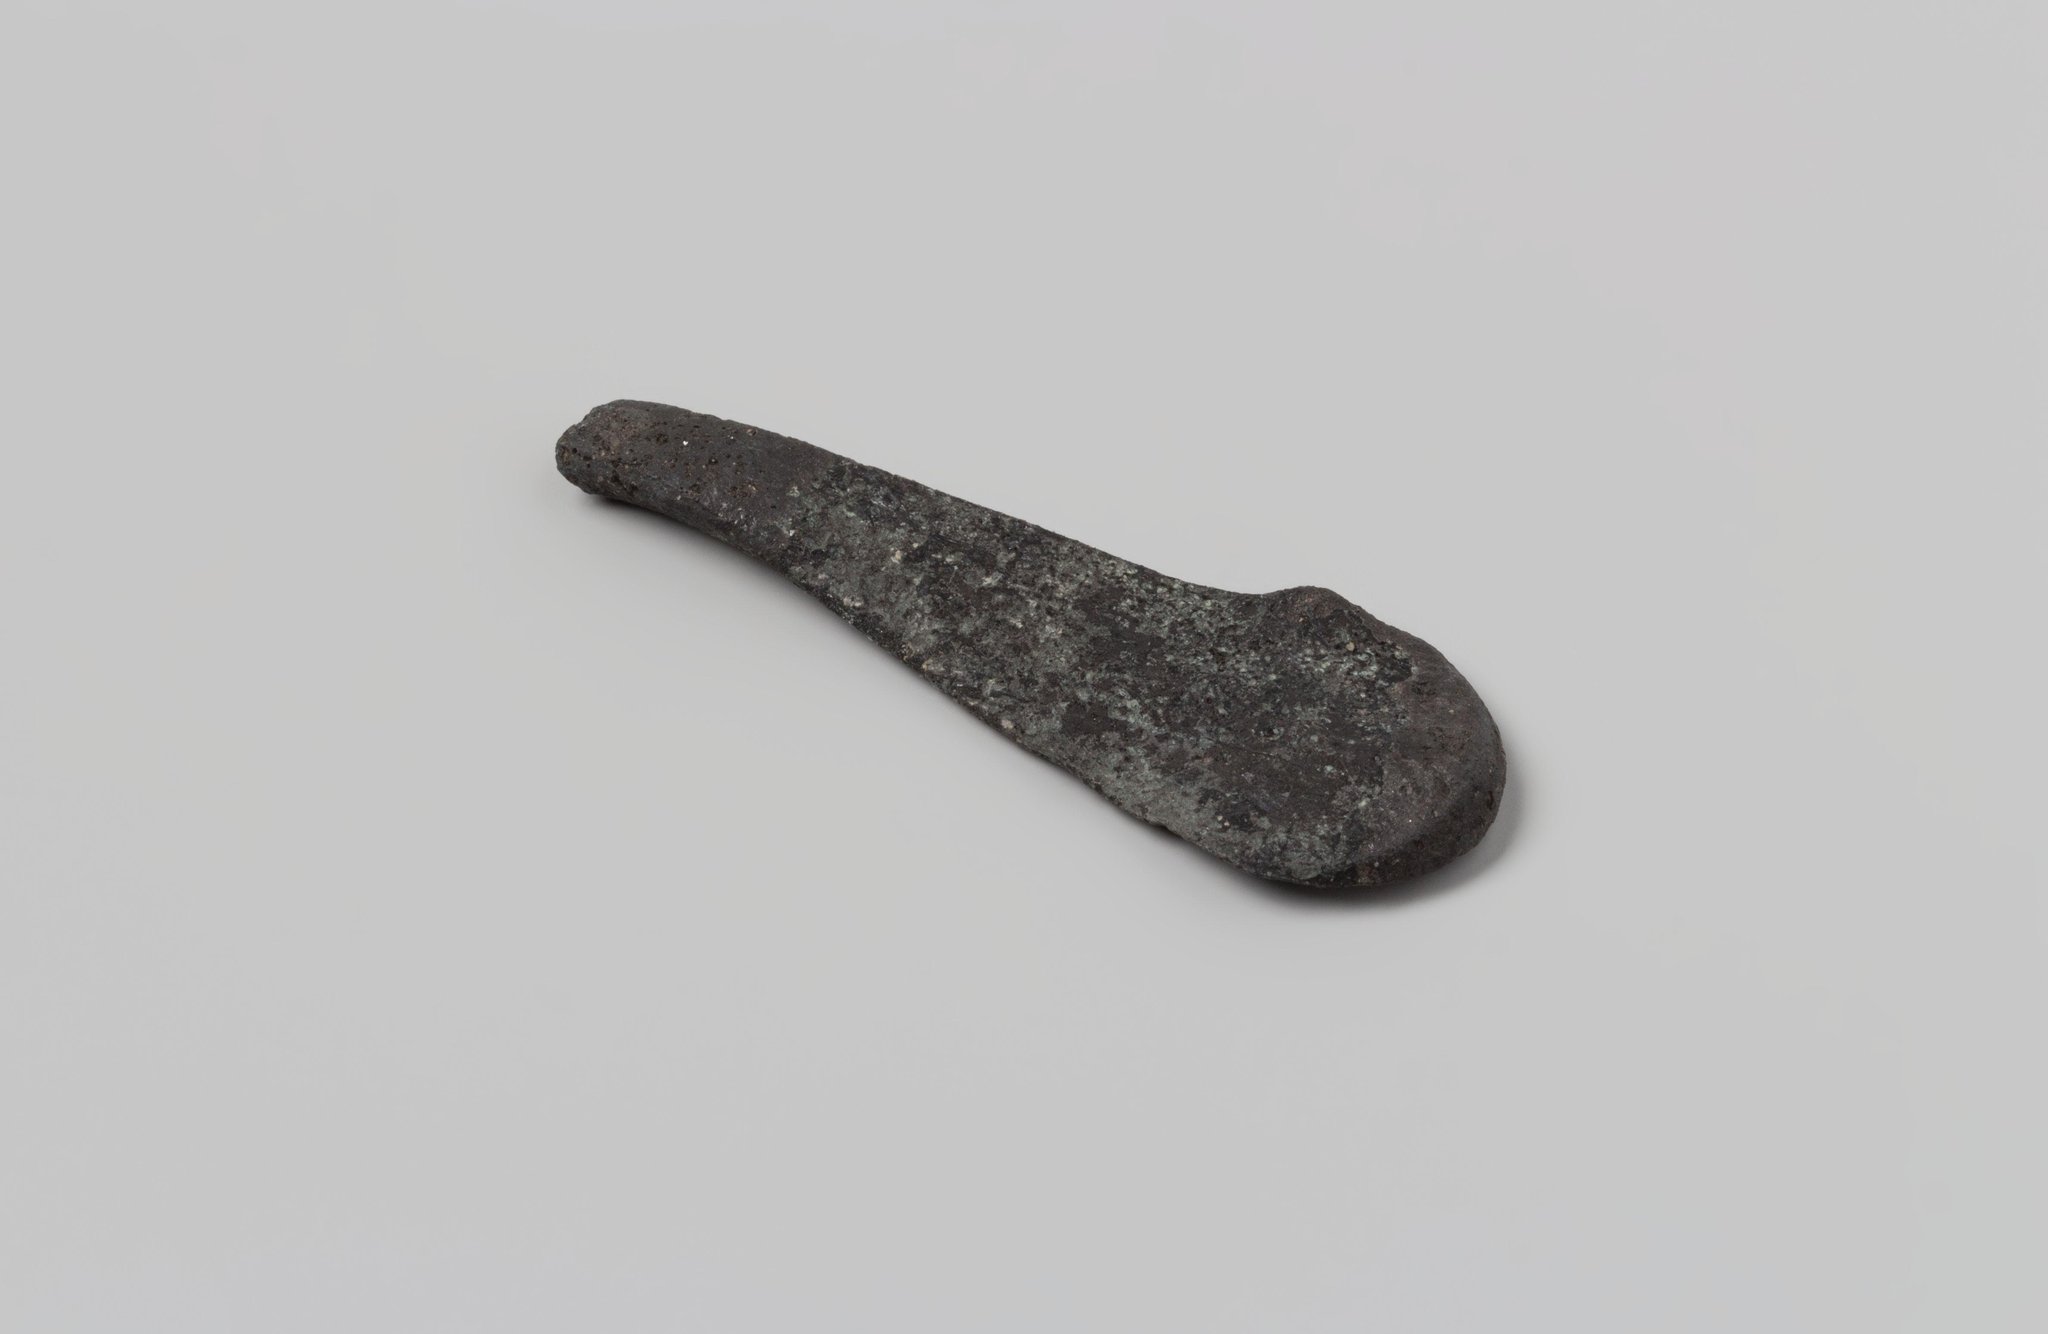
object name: spoon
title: Fragment steel van vork of lepel uit het wrak van de Oost-Indiëvaarder Hollandia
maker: Anonymous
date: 1700-1743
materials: tin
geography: netherlands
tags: verenigde oostindische compagnie, hollandia (schip), annet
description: Cutlery, fragment: stem of fork or spoon; fragm, sim. NG 1980-27H67.